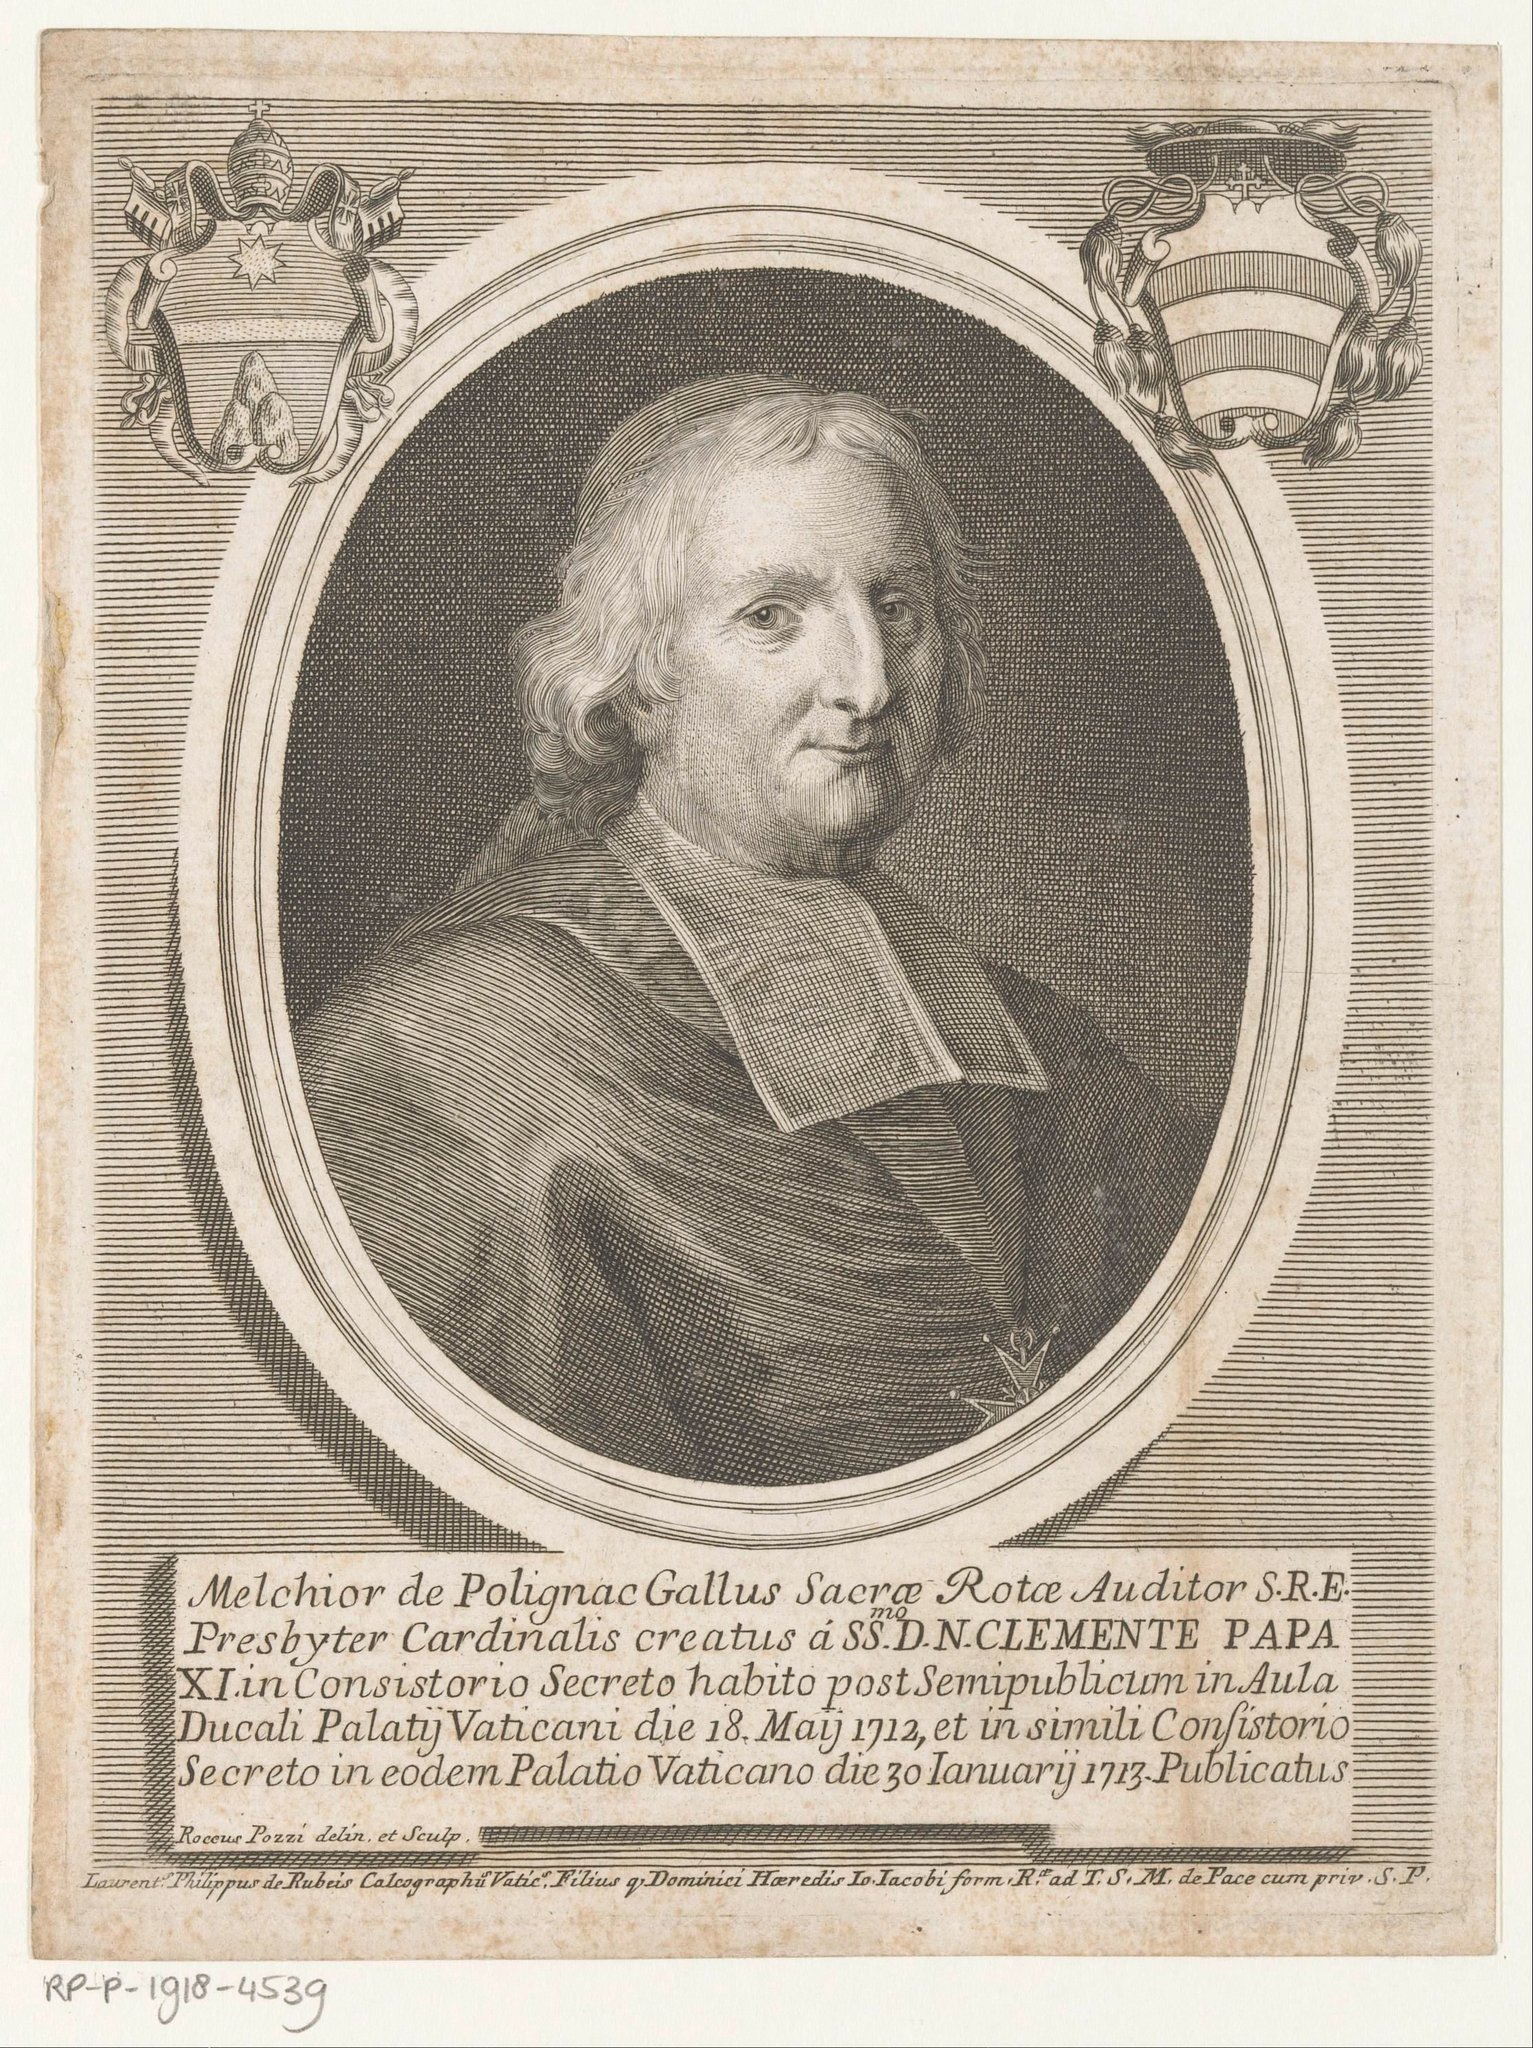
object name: print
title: Portretten van kardinalen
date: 1713-1780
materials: paper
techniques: engraving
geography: rome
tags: france, paris, melchior de polignac, cardinal, historical persons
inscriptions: collector's mark: Lugt 2228